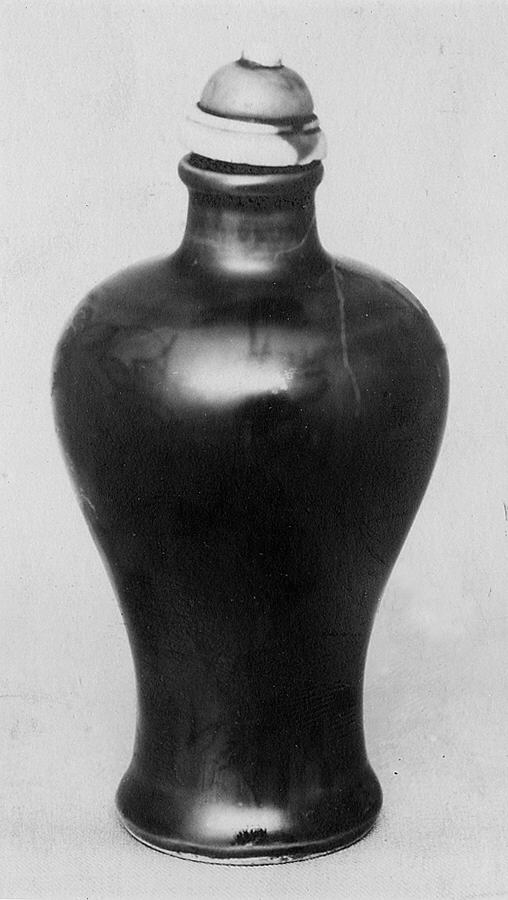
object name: snuff bottle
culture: chinese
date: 1736-1795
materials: porcelain